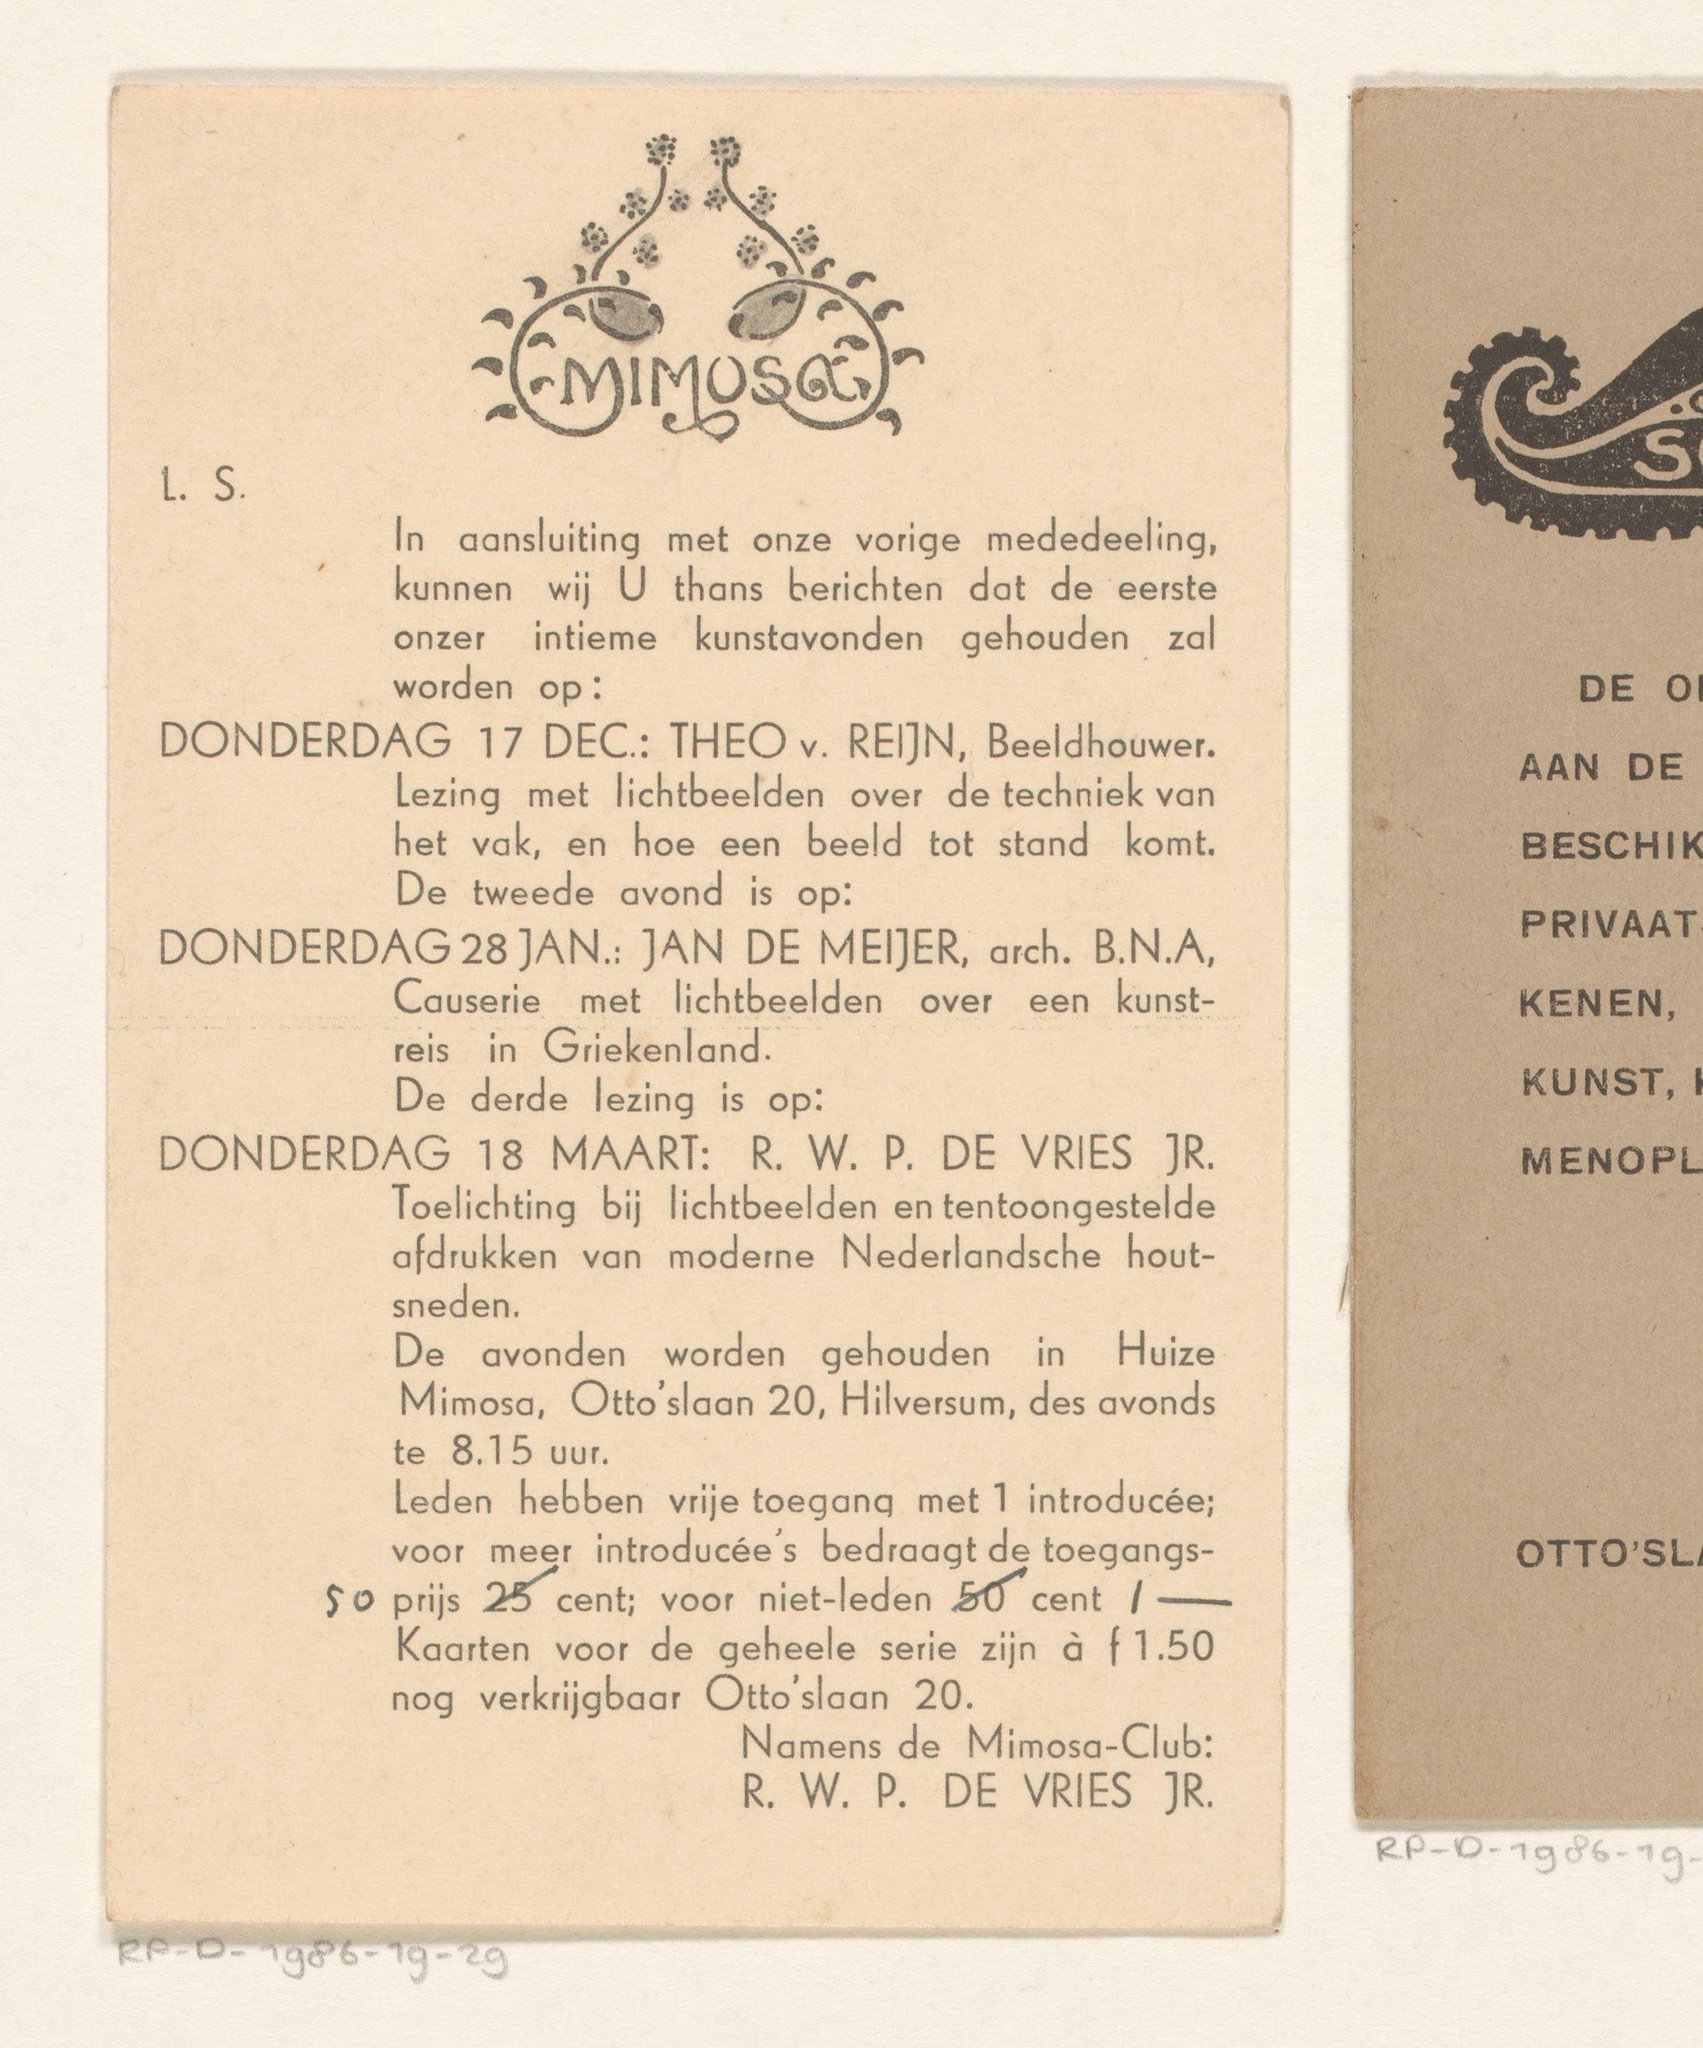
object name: print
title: Briefkaart aan anoniem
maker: reinier willem petrus de vries (1874-1953)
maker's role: draughtsman, print maker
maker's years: 1874-1953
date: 1884-1952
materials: paper, pencil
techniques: relief print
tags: flowers ~ ornament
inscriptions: annotation: ‘W.O.J. Nieuwenkamp/ La[...] in Bali’, collector's mark: ‘R:MVS.’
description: Programma voor kunstavonden van de Mimosaclub.